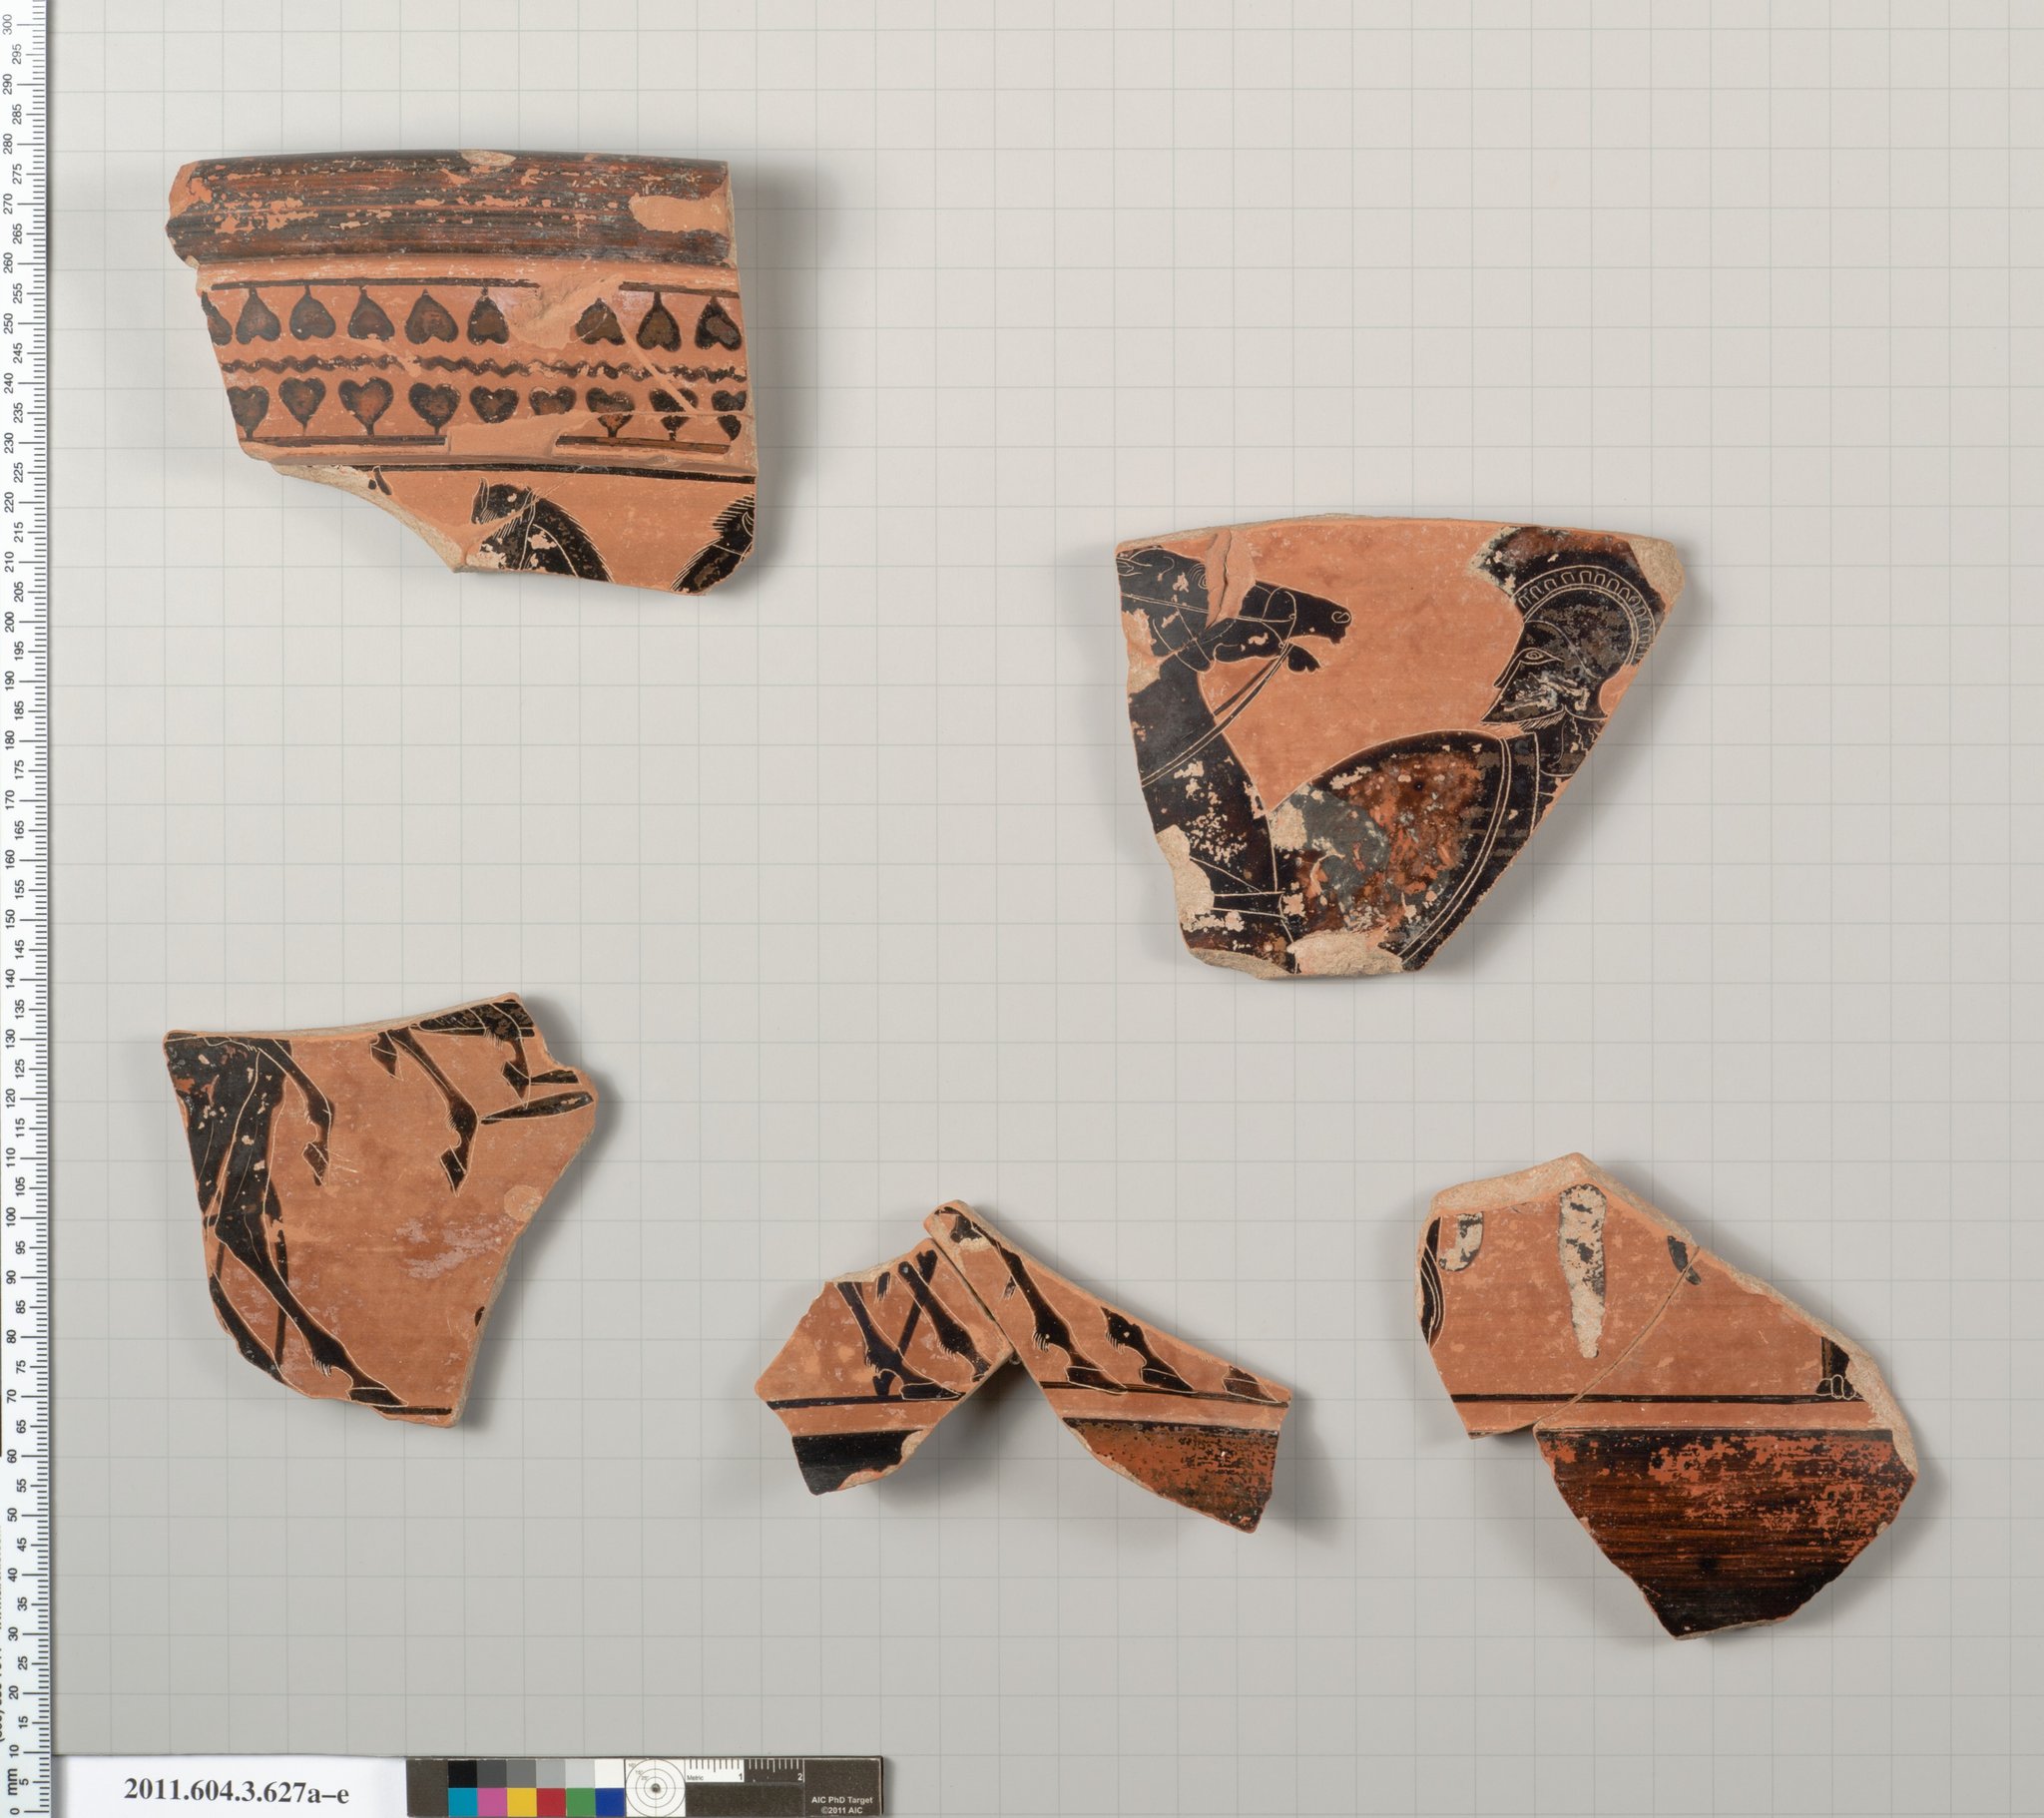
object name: calyx krater fragment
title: Terracotta fragments of a calyx-krater (bowl for mixing wine and water)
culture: greek, attic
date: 525-501 BCE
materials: terracotta